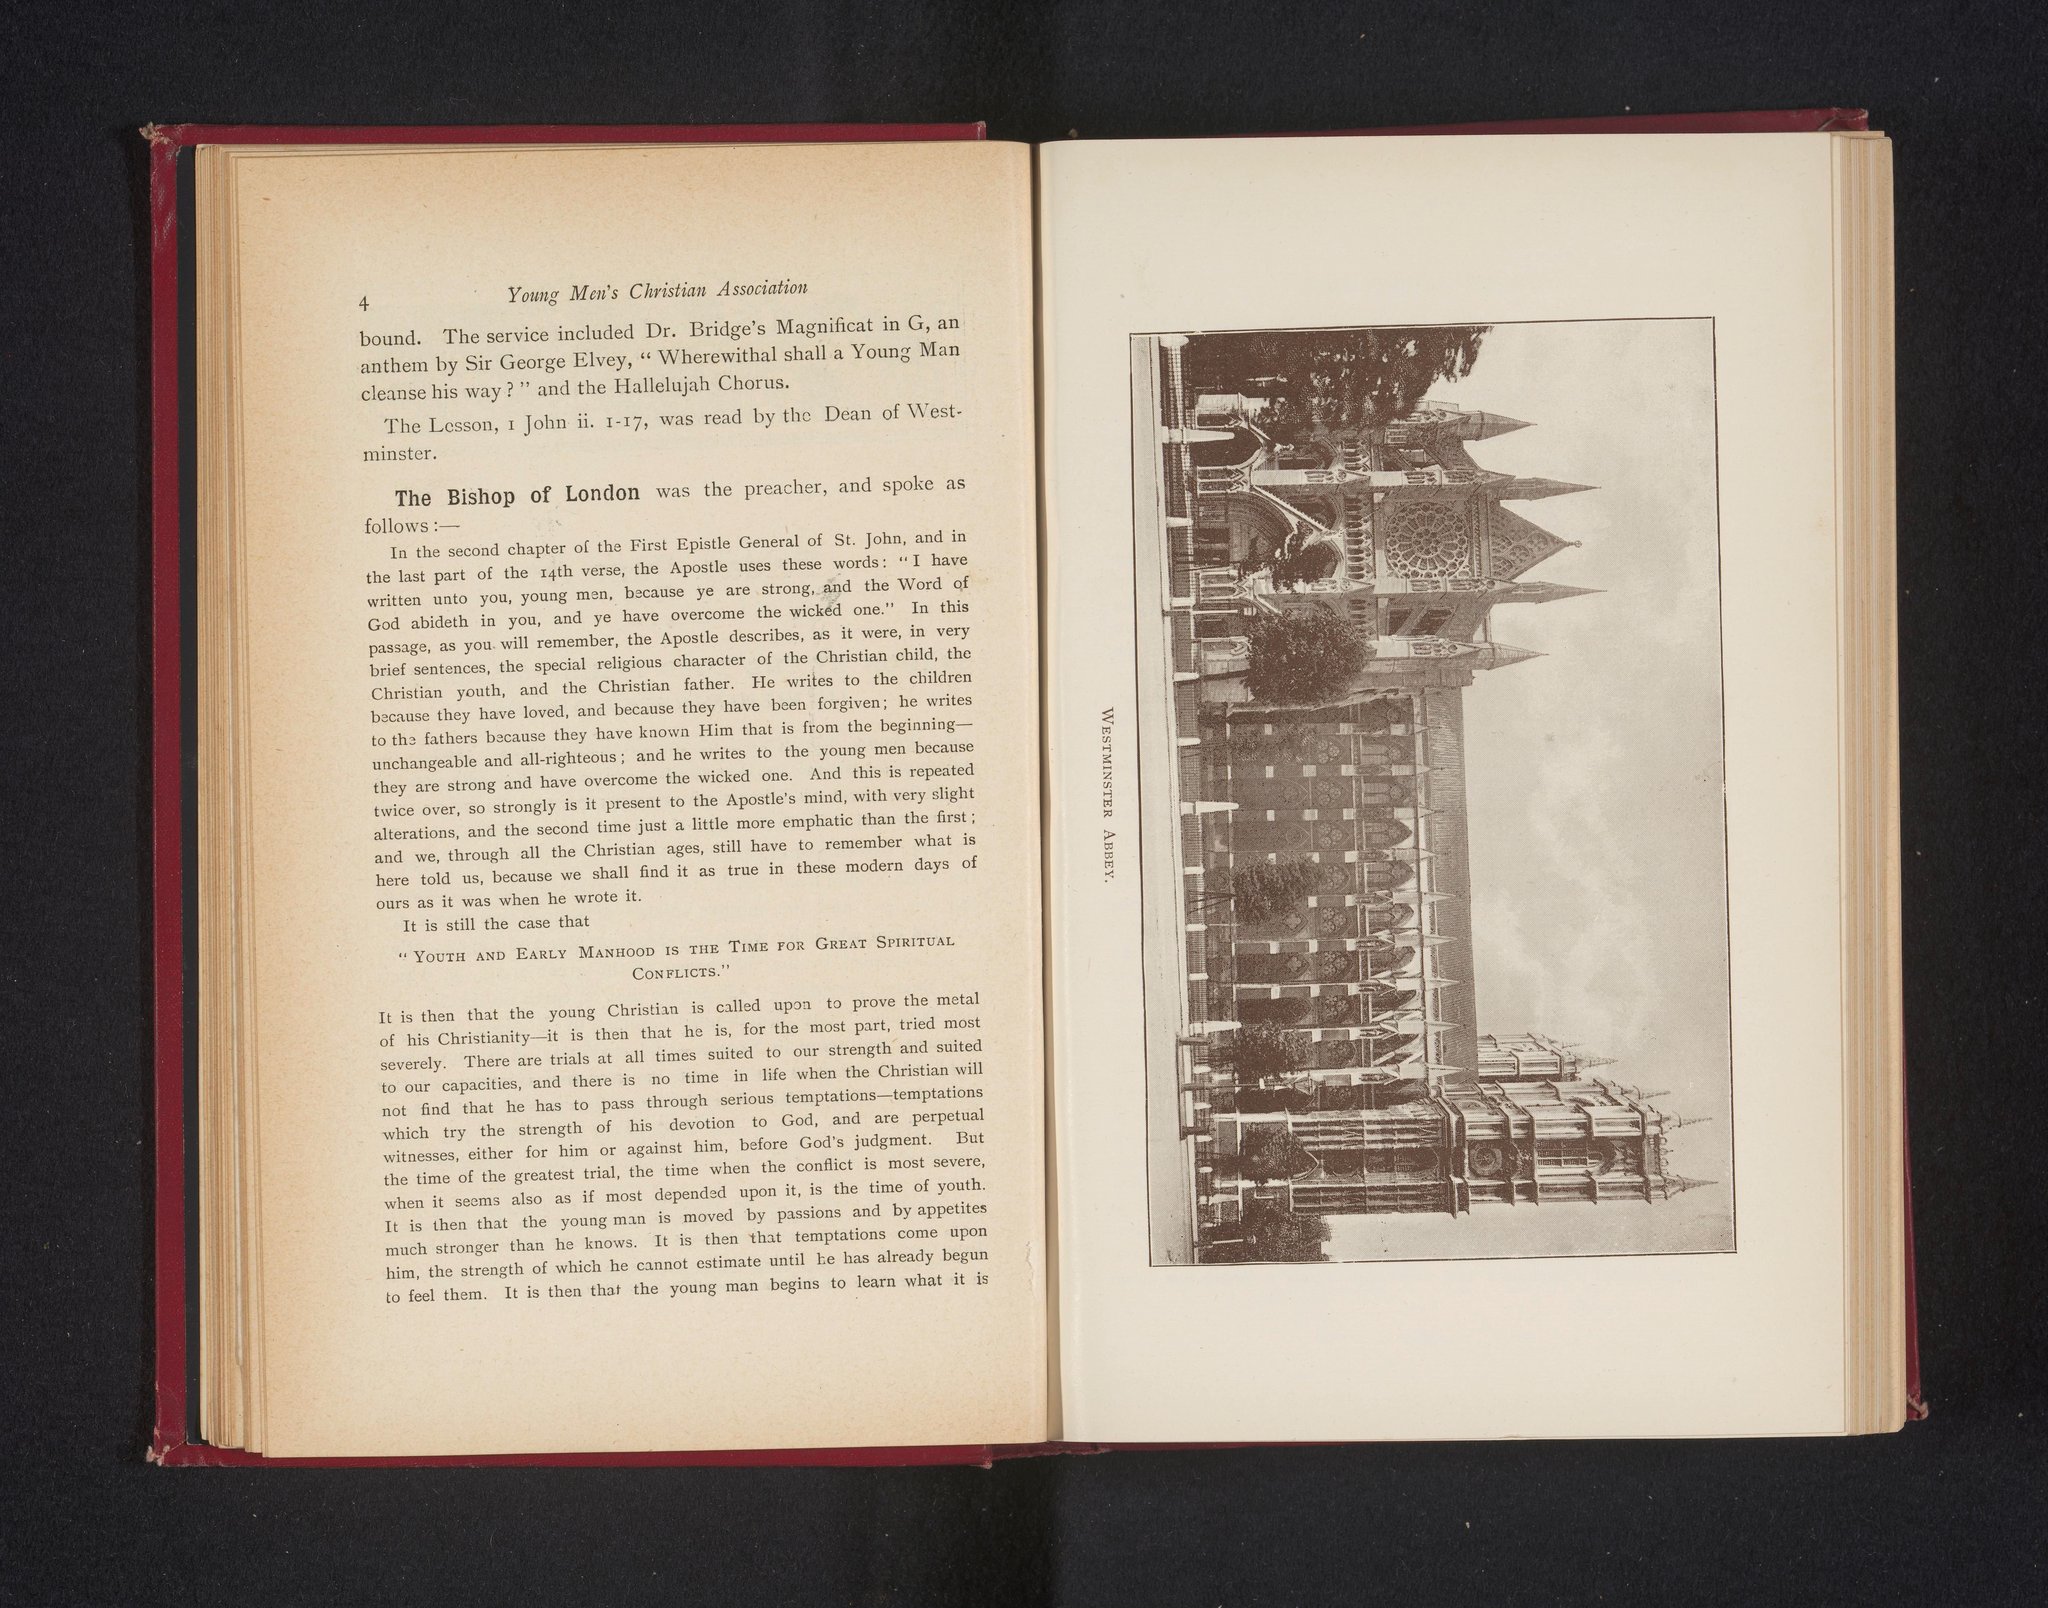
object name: page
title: Westminster Abbey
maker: Anonymous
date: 1890-1895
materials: paper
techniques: autotype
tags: abbey, monastery, convent ~ roman catholic church, westminster abbey